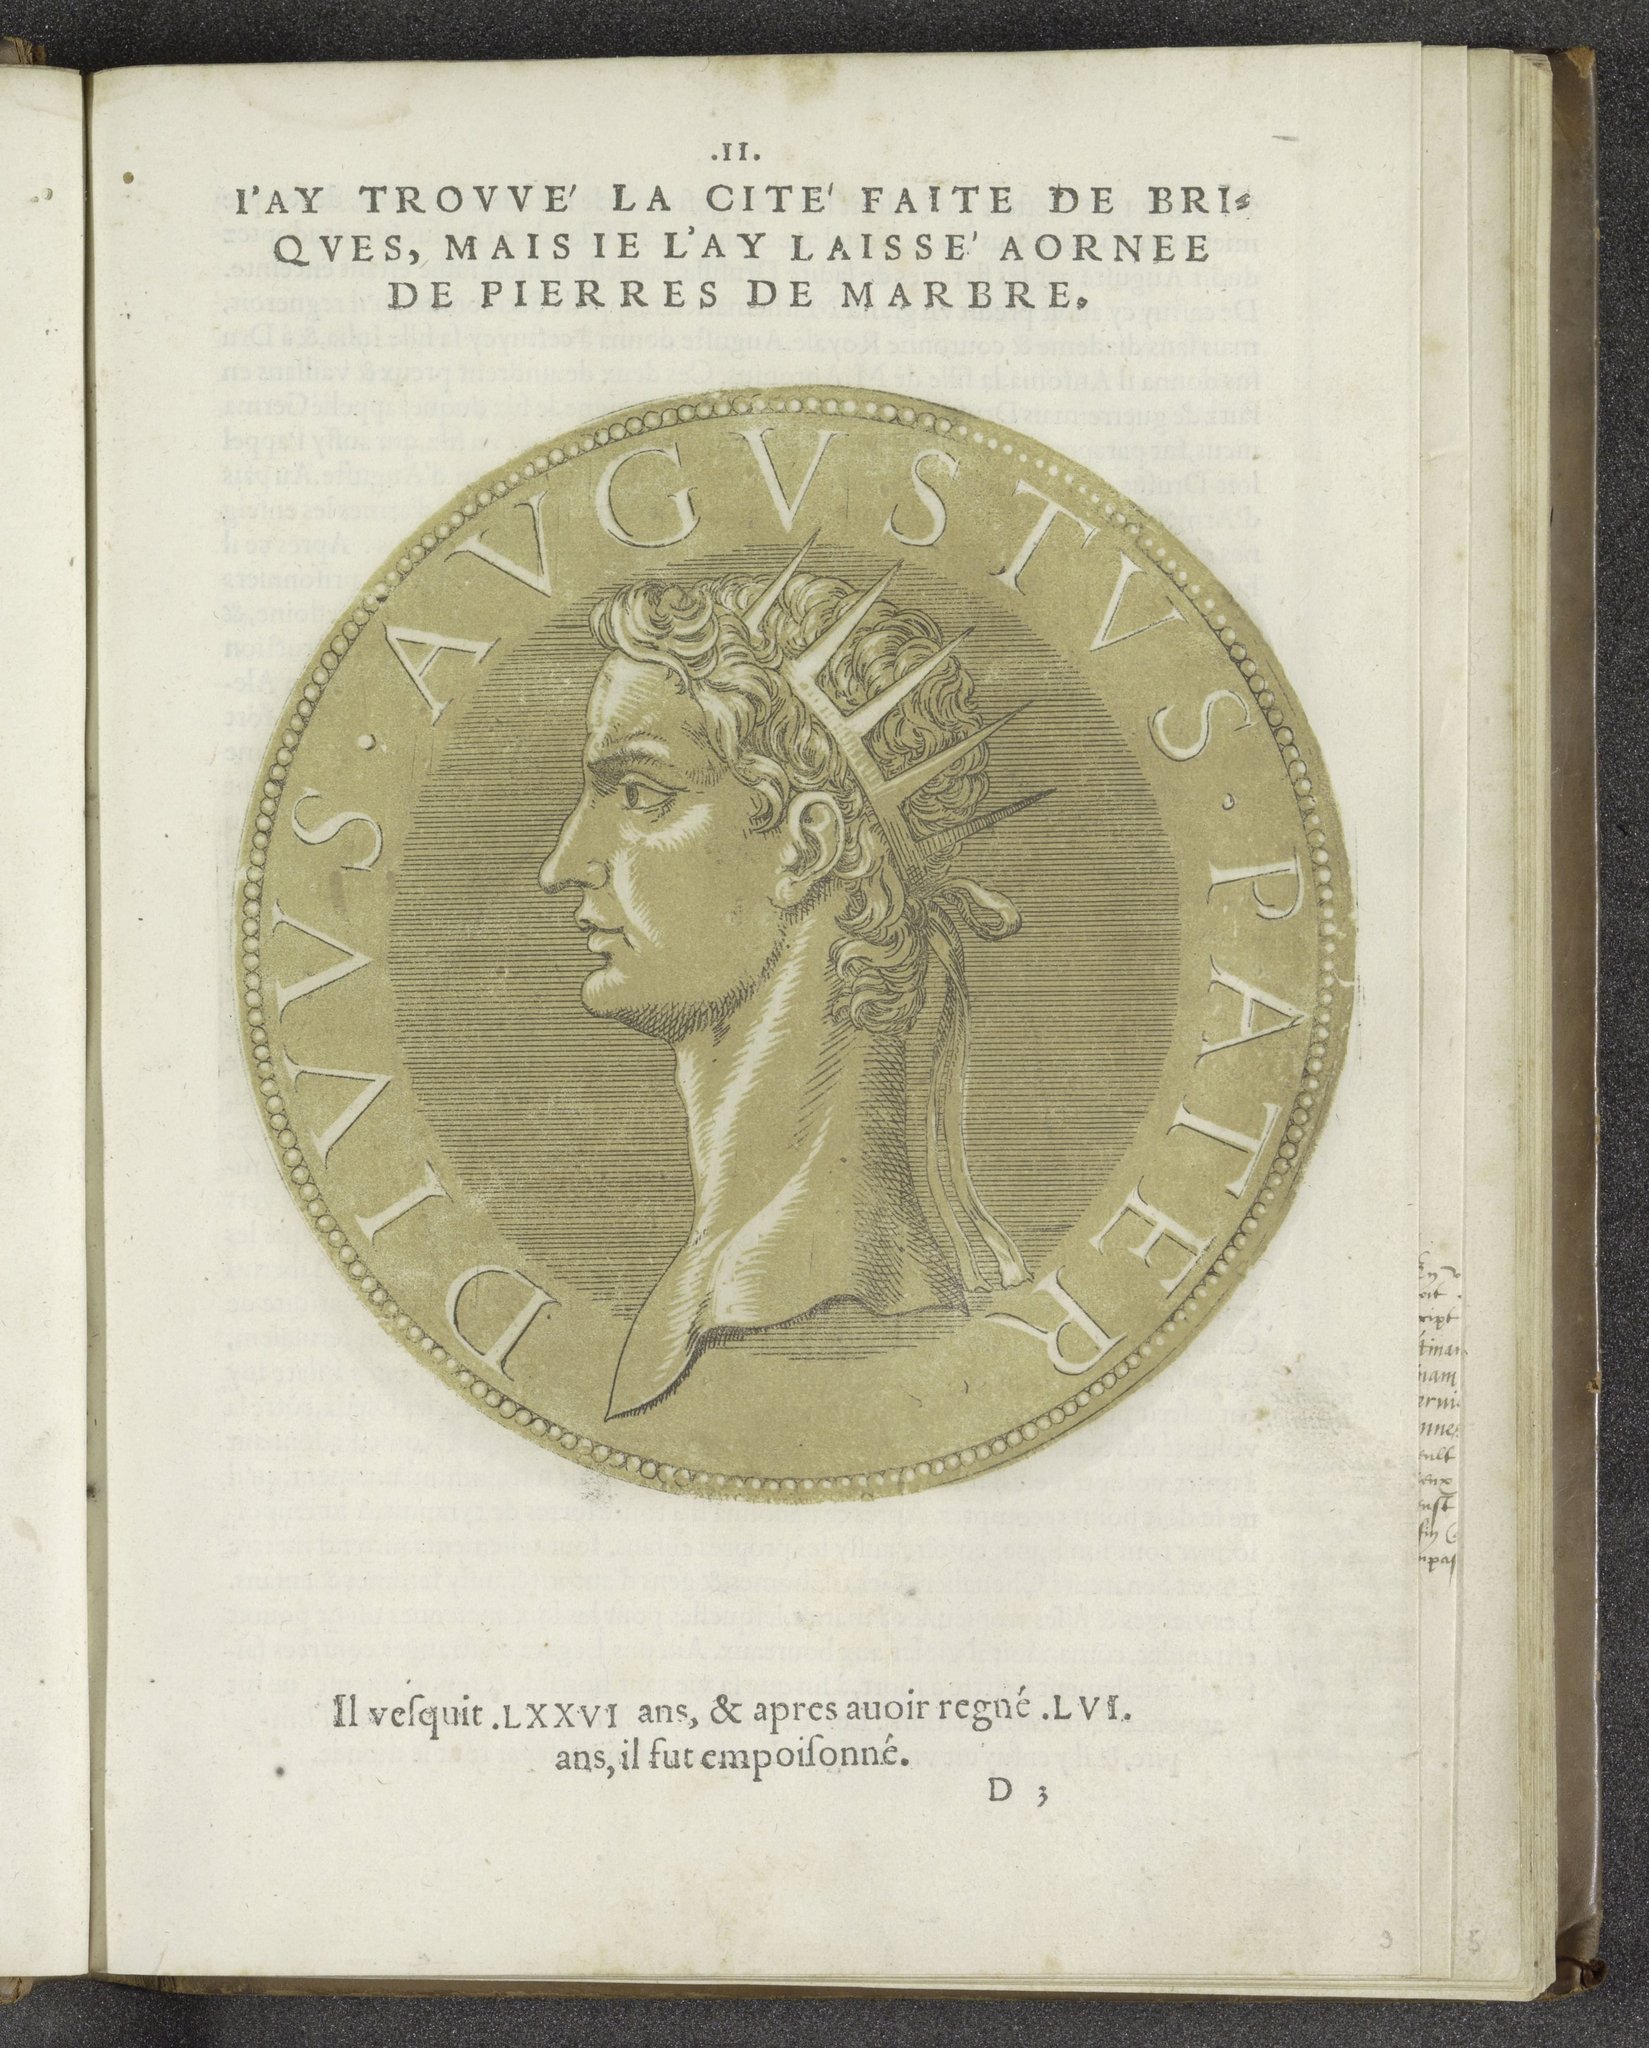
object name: print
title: Portret van keizer Augustus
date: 1557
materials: paper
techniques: woodcut, etching, letterpress printing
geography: antwerp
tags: emperor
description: Portret van keizer Augustus op een munt, met randschrift. De prent maakt deel uit van een boek over de keizers vanaf Julius Caesar tot en met Karel V en zijn broer Ferdinand.